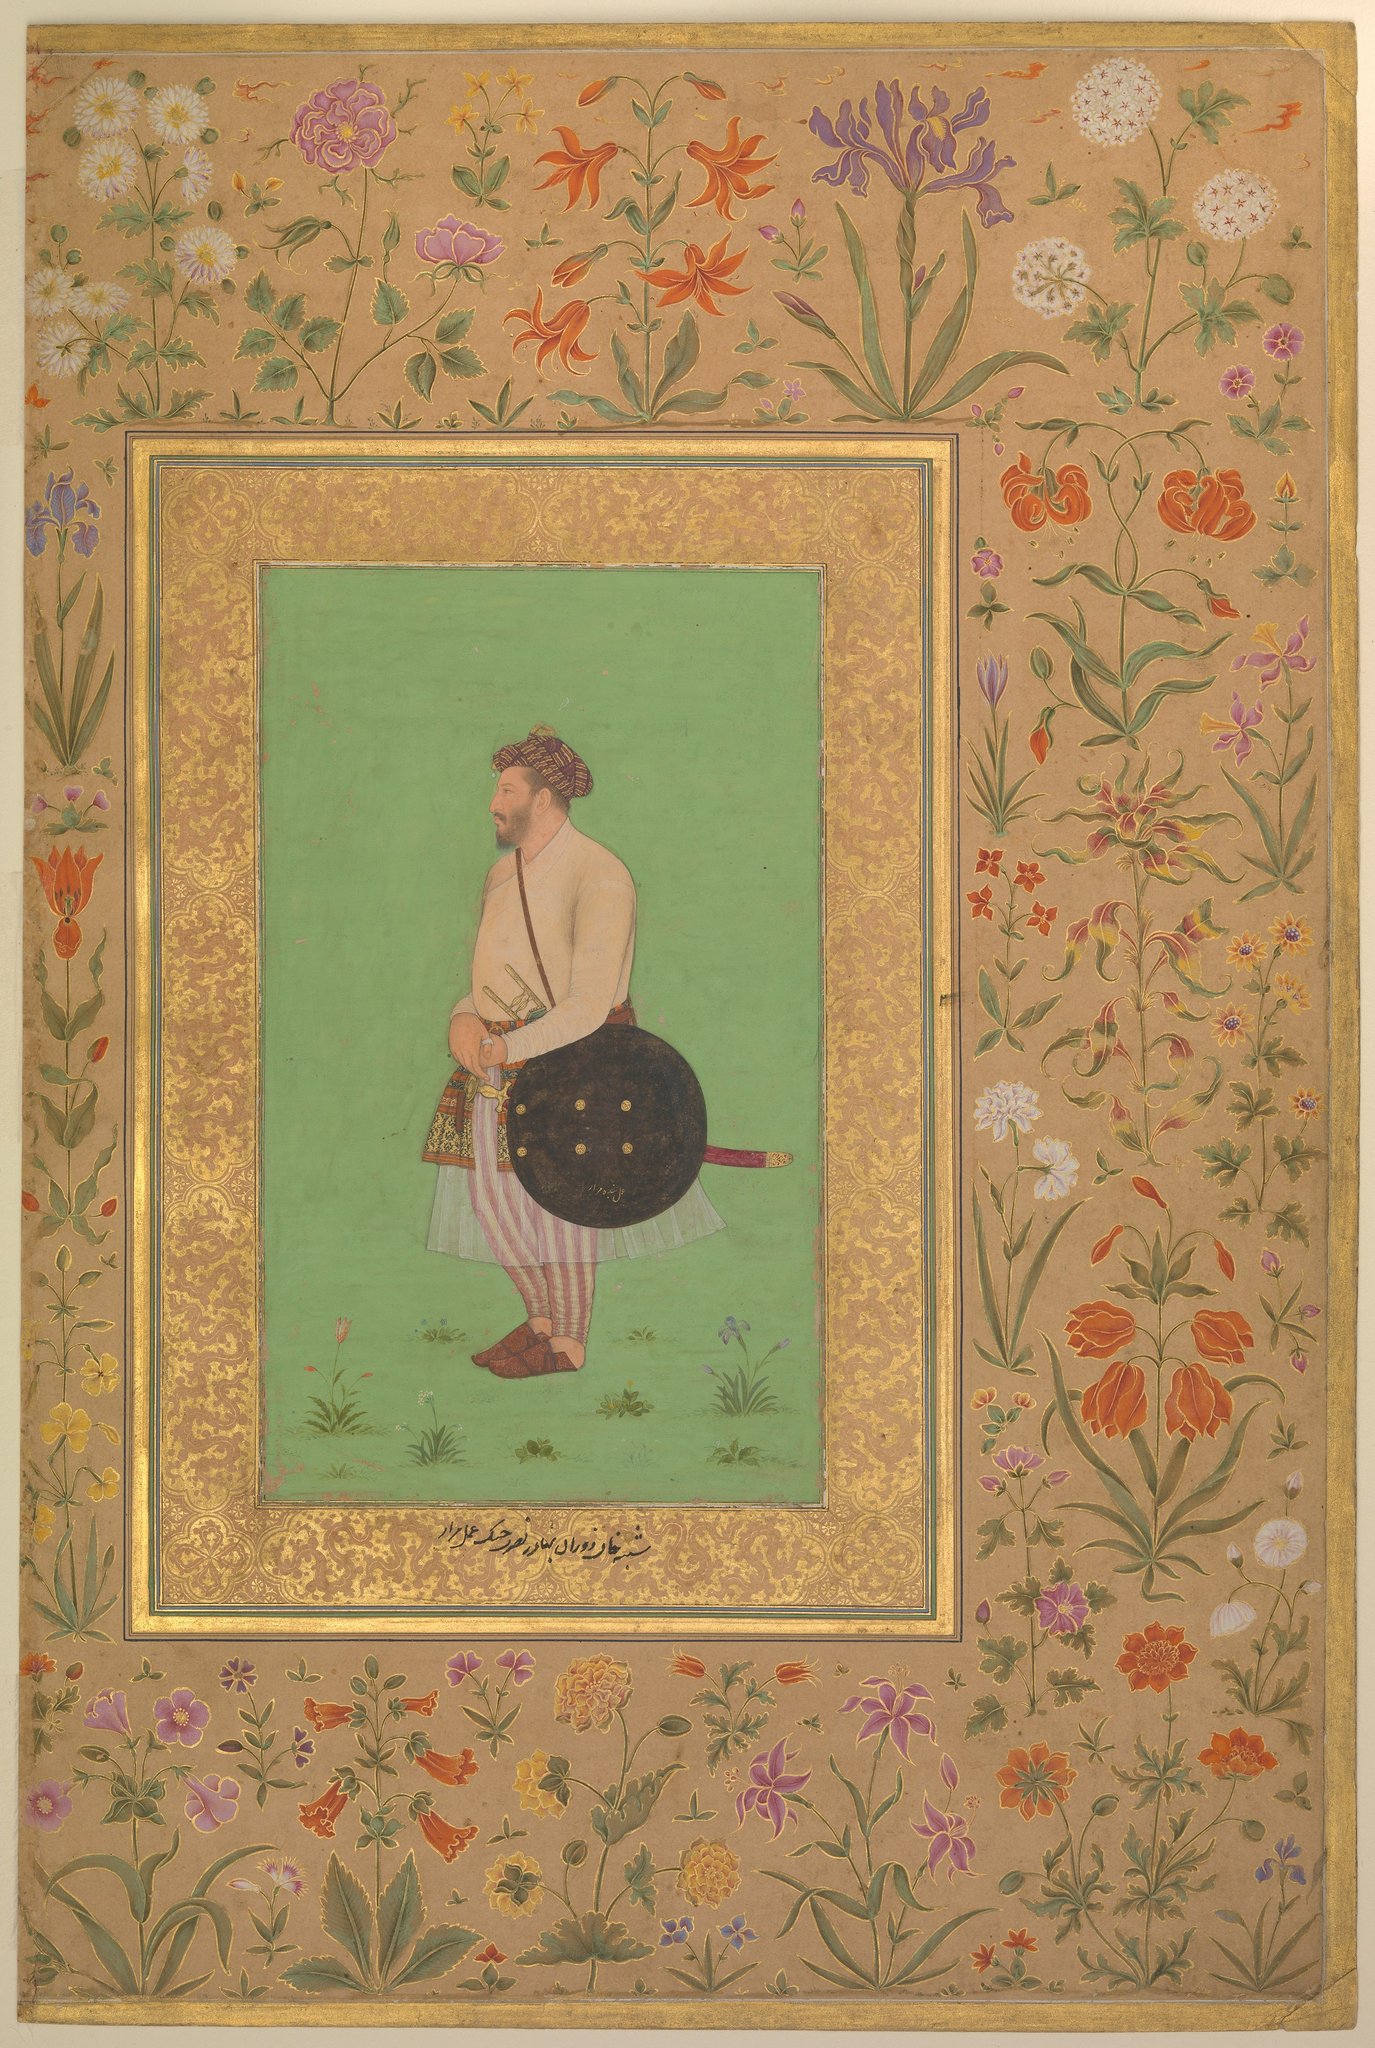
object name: album leaf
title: "Portrait of Khan Dauran Bahadur Nusrat Jang", Folio from the Shah Jahan Album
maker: murad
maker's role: artist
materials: gold, ink, paper, watercolor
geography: india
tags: men,profiles